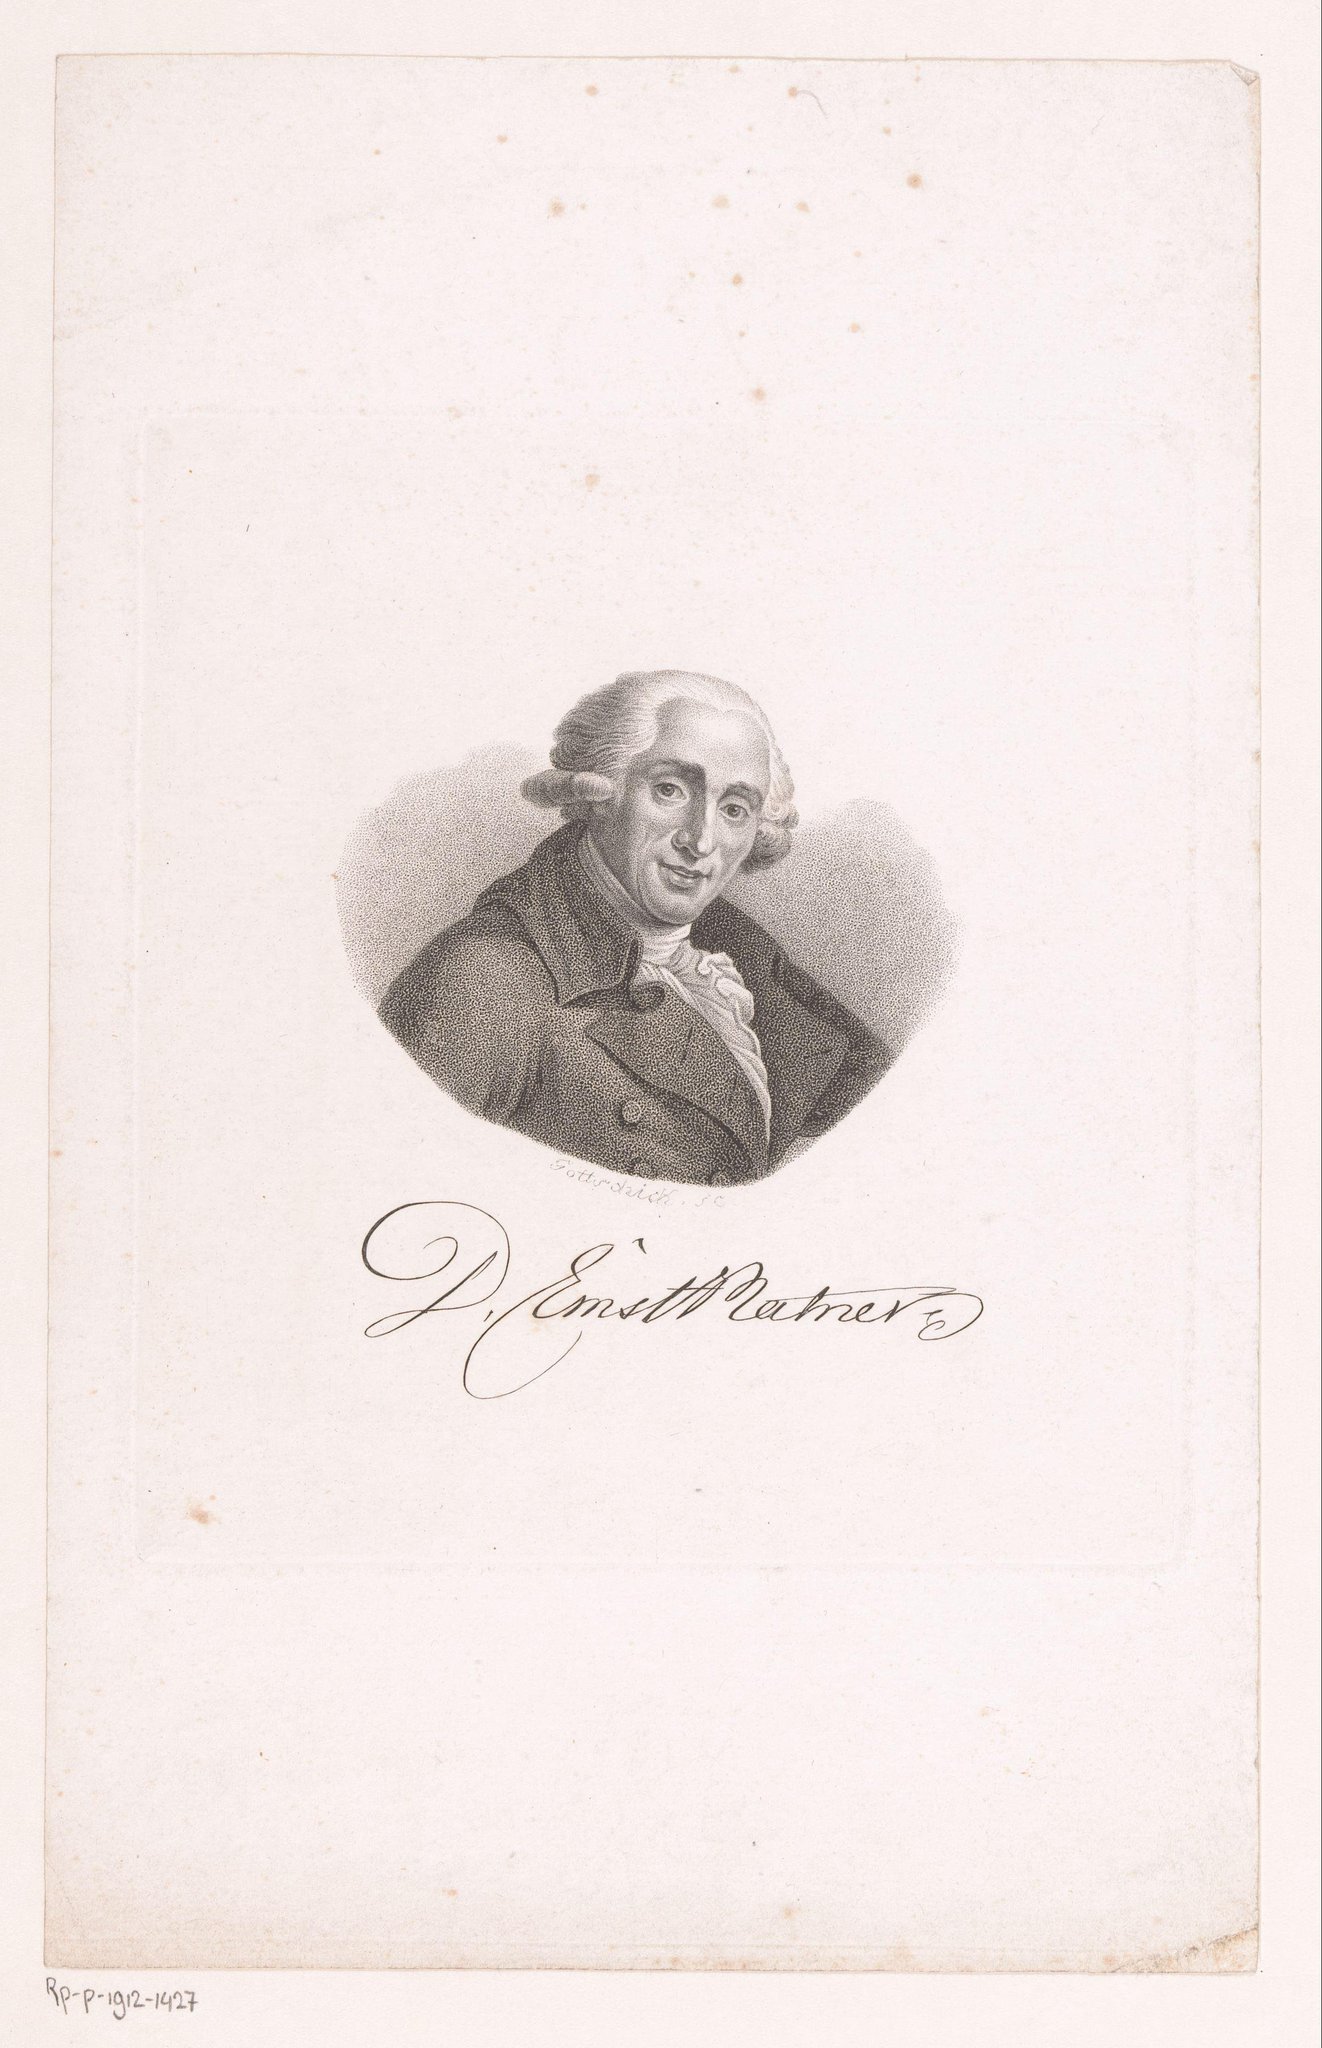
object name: print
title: Portret van D. Ernst Matner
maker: johann christian benjamin gottschick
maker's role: print maker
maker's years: 1776-1844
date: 1786-1844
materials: paper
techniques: stippling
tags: historical persons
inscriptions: collector's mark: Lugt 2228